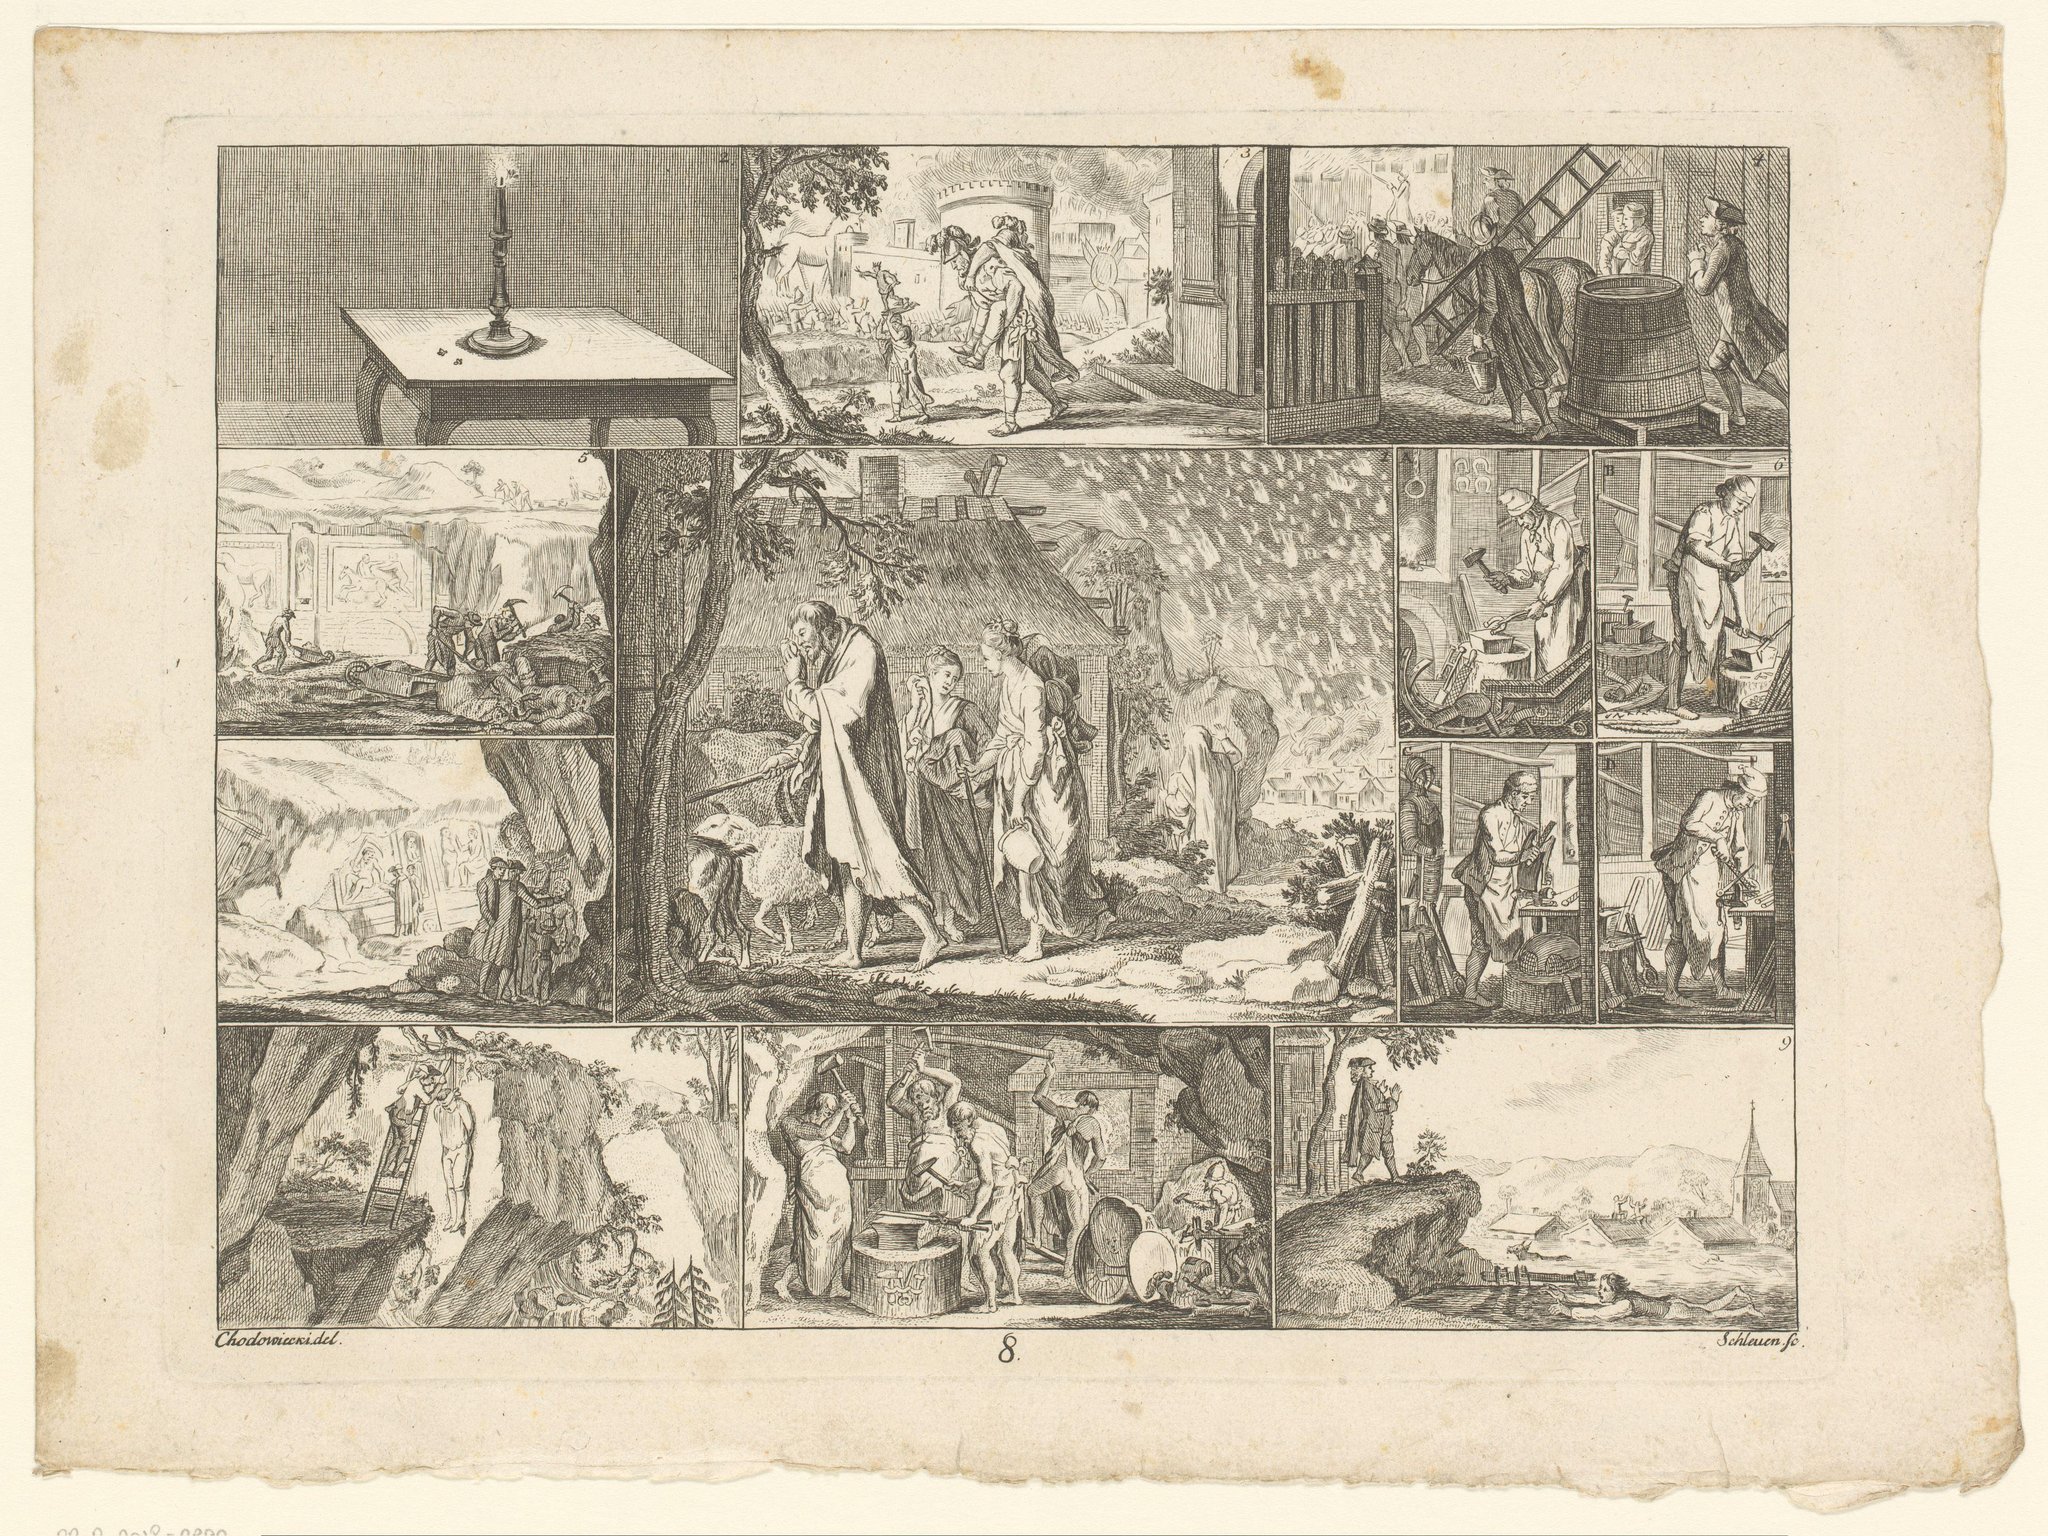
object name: print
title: Blad met uiteenlopende encyclopedische voorstellingen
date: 1784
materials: paper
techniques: engraving, etching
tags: 'pius aeneas': aeneas, leading ascanius, escapes from burning troy, carrying his father anchises with the penates; his wife creusa, who sets out with them, is lost on the way, the destruction of sodom and gomorrah: lot and his family flee to zoar, carrying their belongings; an angel may be showing the way (genesis 19:24-29), lot's wife looks back at the city and is transformed into a pillar of salt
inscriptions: collector's mark: Lugt 2228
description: Maakt deel uit van een serie encyclopedische prenten door verschillende kunstenaars naar ontwerp van Daniel Nikolaus Chodowiecki bij Johann Sigmund Stoy's 'Bilder-Akademie für die Jugend', uitgegeven te Neurenberg in 1784. De prenten waren bedoeld voor kinderen om uit te knippen, op kaarten te plakken en vervolgens op logische wijze te rangschikken (zie Heesen, Anke te. The World in a Box: The Story of an Eighteenth-Century Picture Encyclopedia. Chicago: University of Chicago Press, 2002).